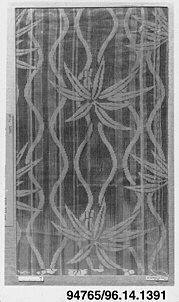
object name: textile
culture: japanese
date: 1701-1900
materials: silk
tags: leaves